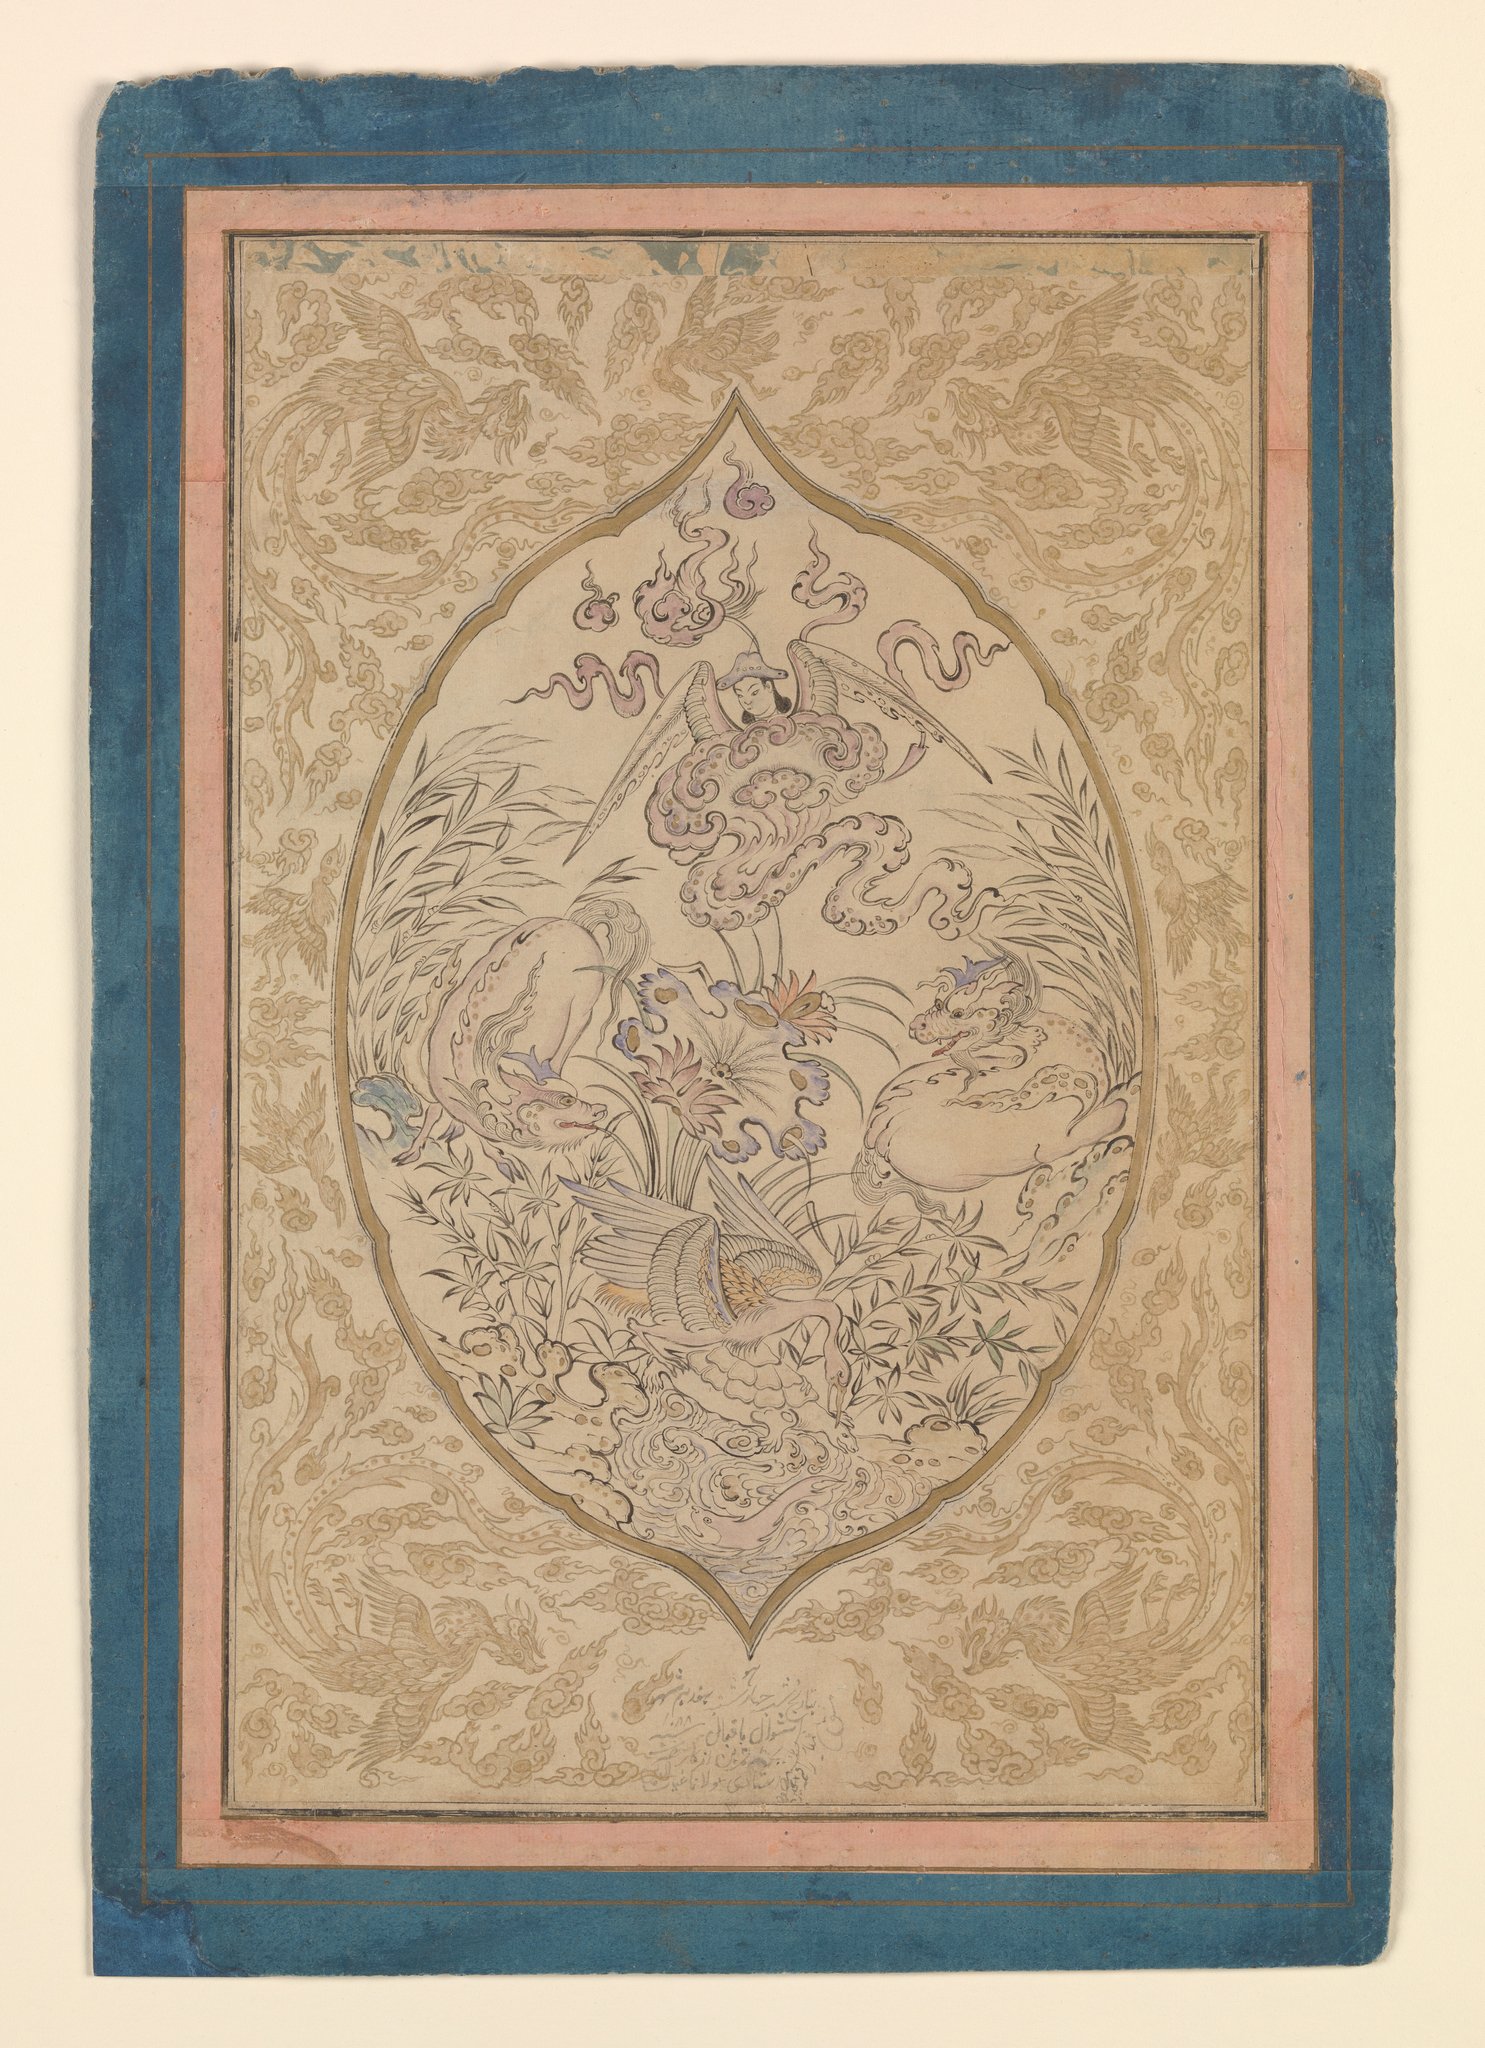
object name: illustrated single work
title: A Gathering of Mythical Creatures around a Lotus Leaf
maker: mu'in musavvir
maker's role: artist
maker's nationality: iranian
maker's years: 1605-1722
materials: ink, paper, watercolor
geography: iran